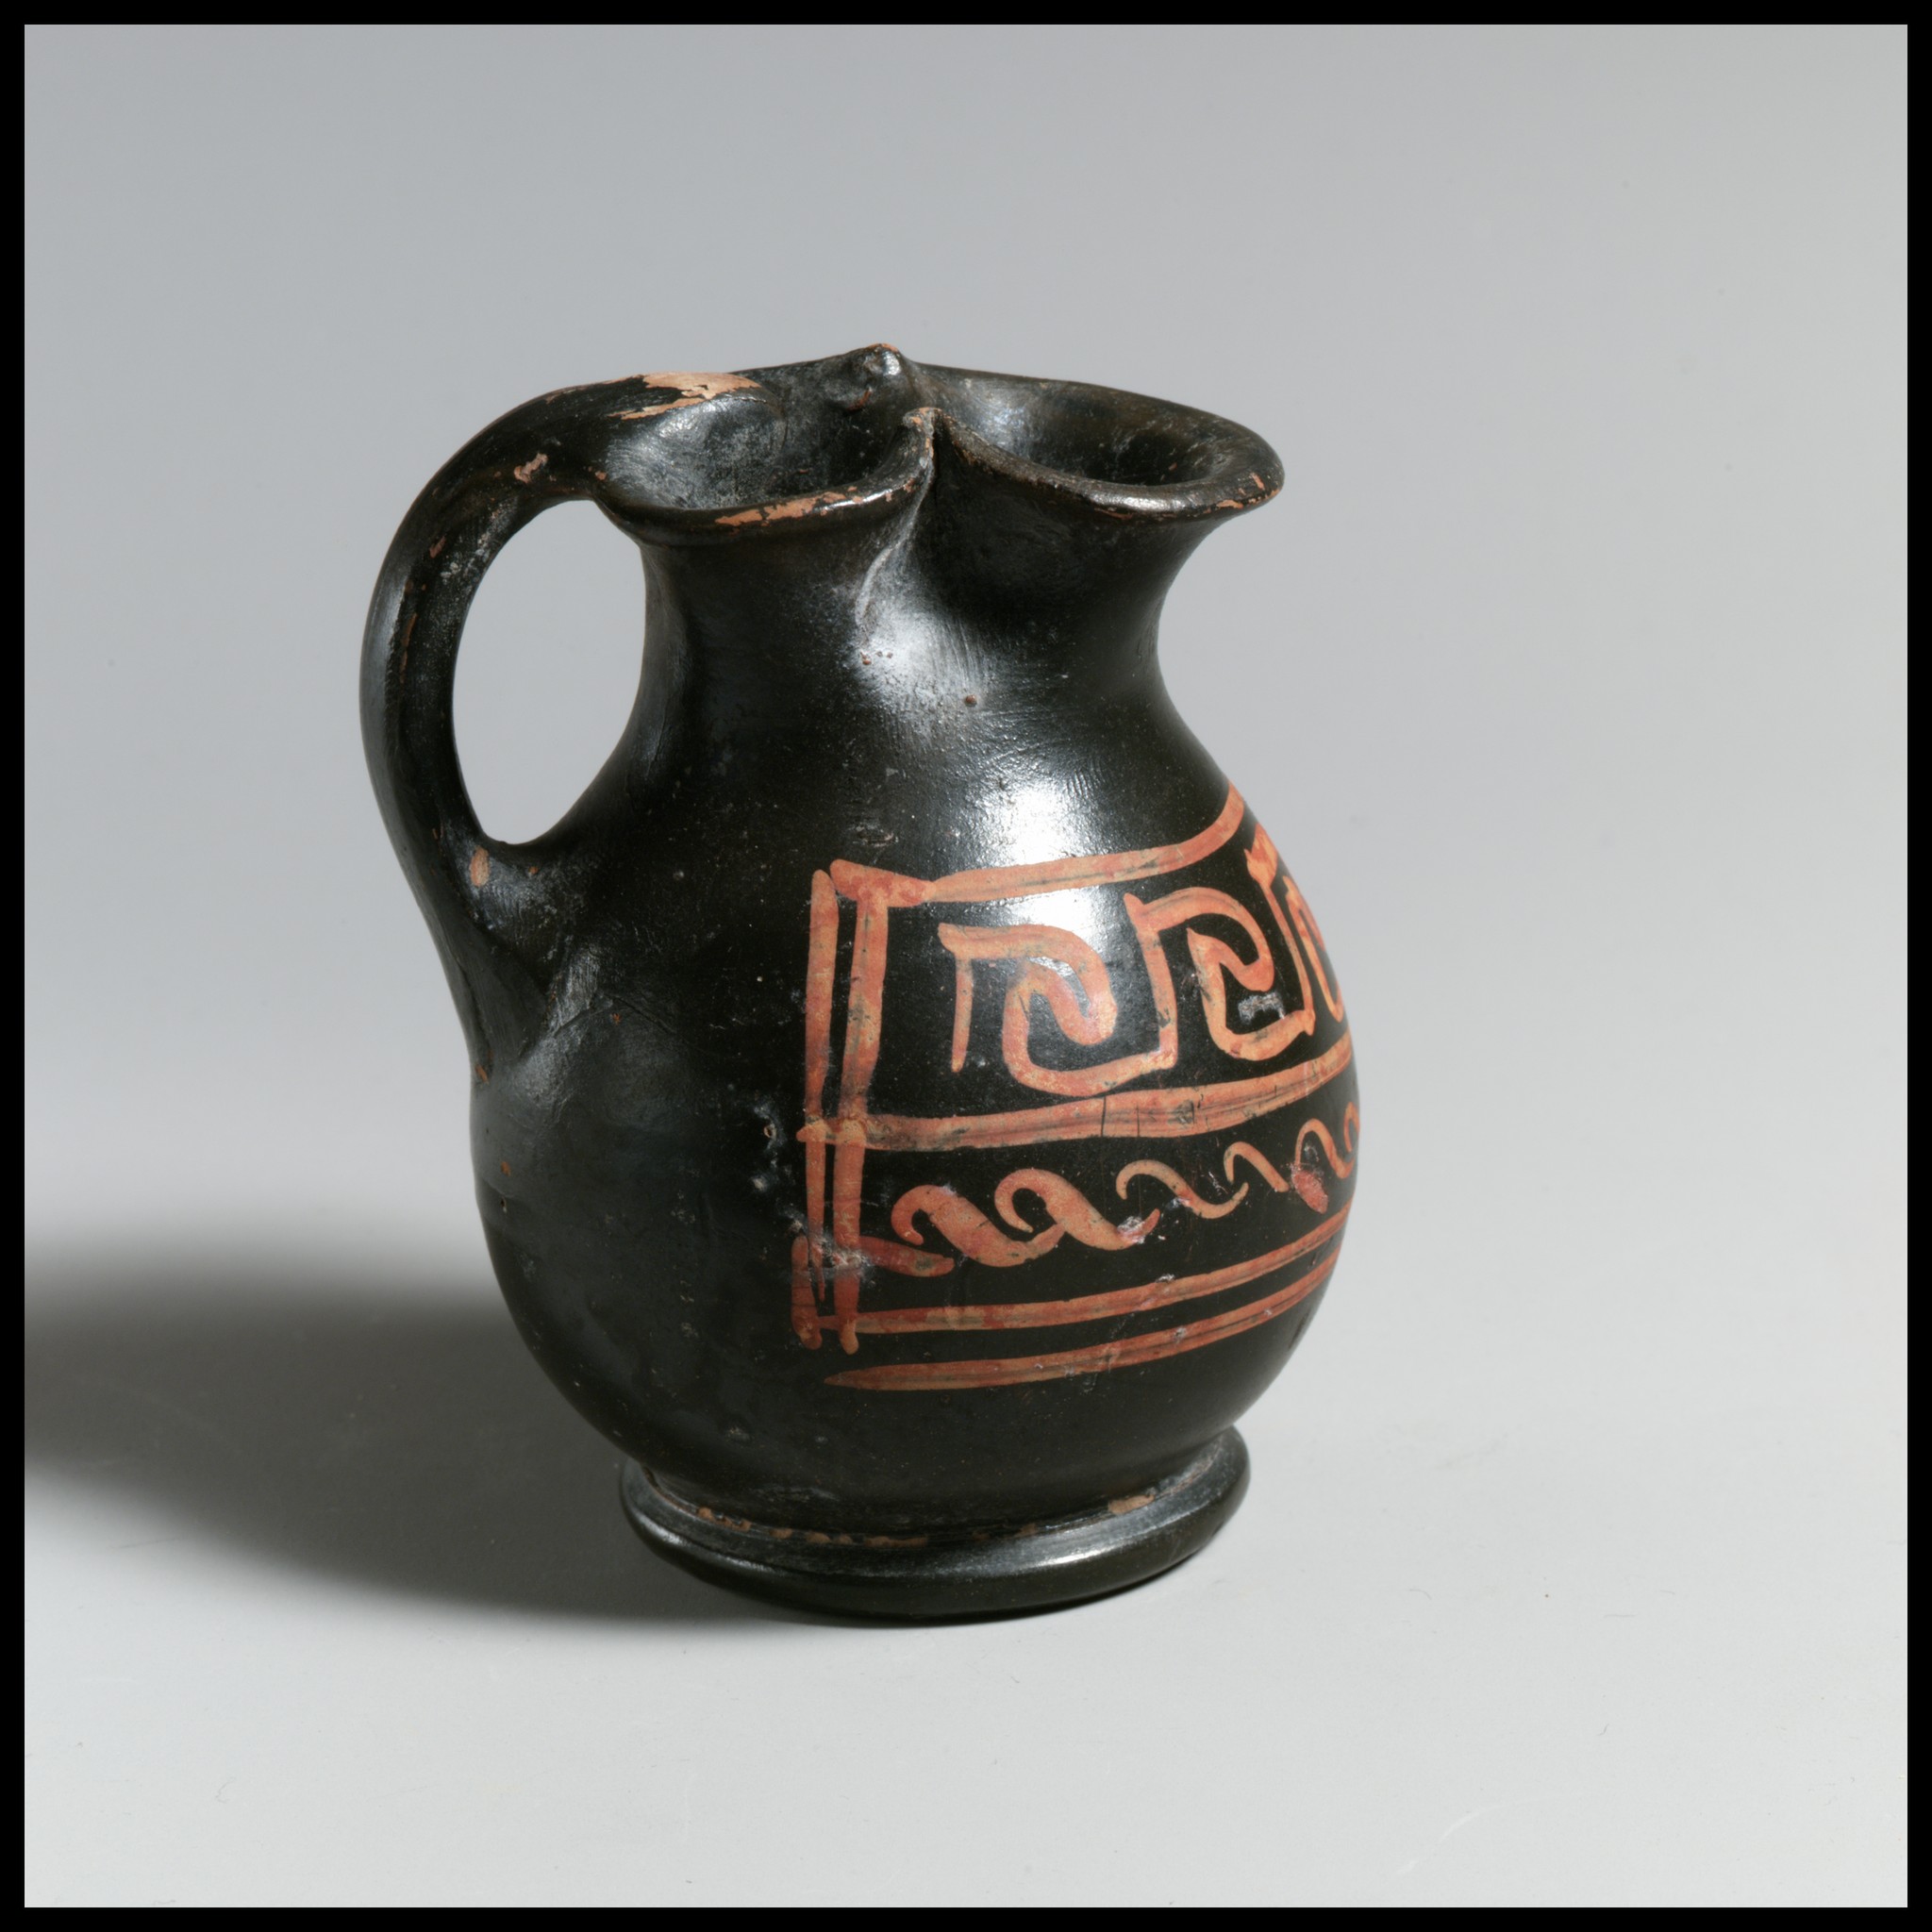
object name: oinochoe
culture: greek, south italian, apulian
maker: xenon group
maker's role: artist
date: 400-301 BCE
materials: terracotta